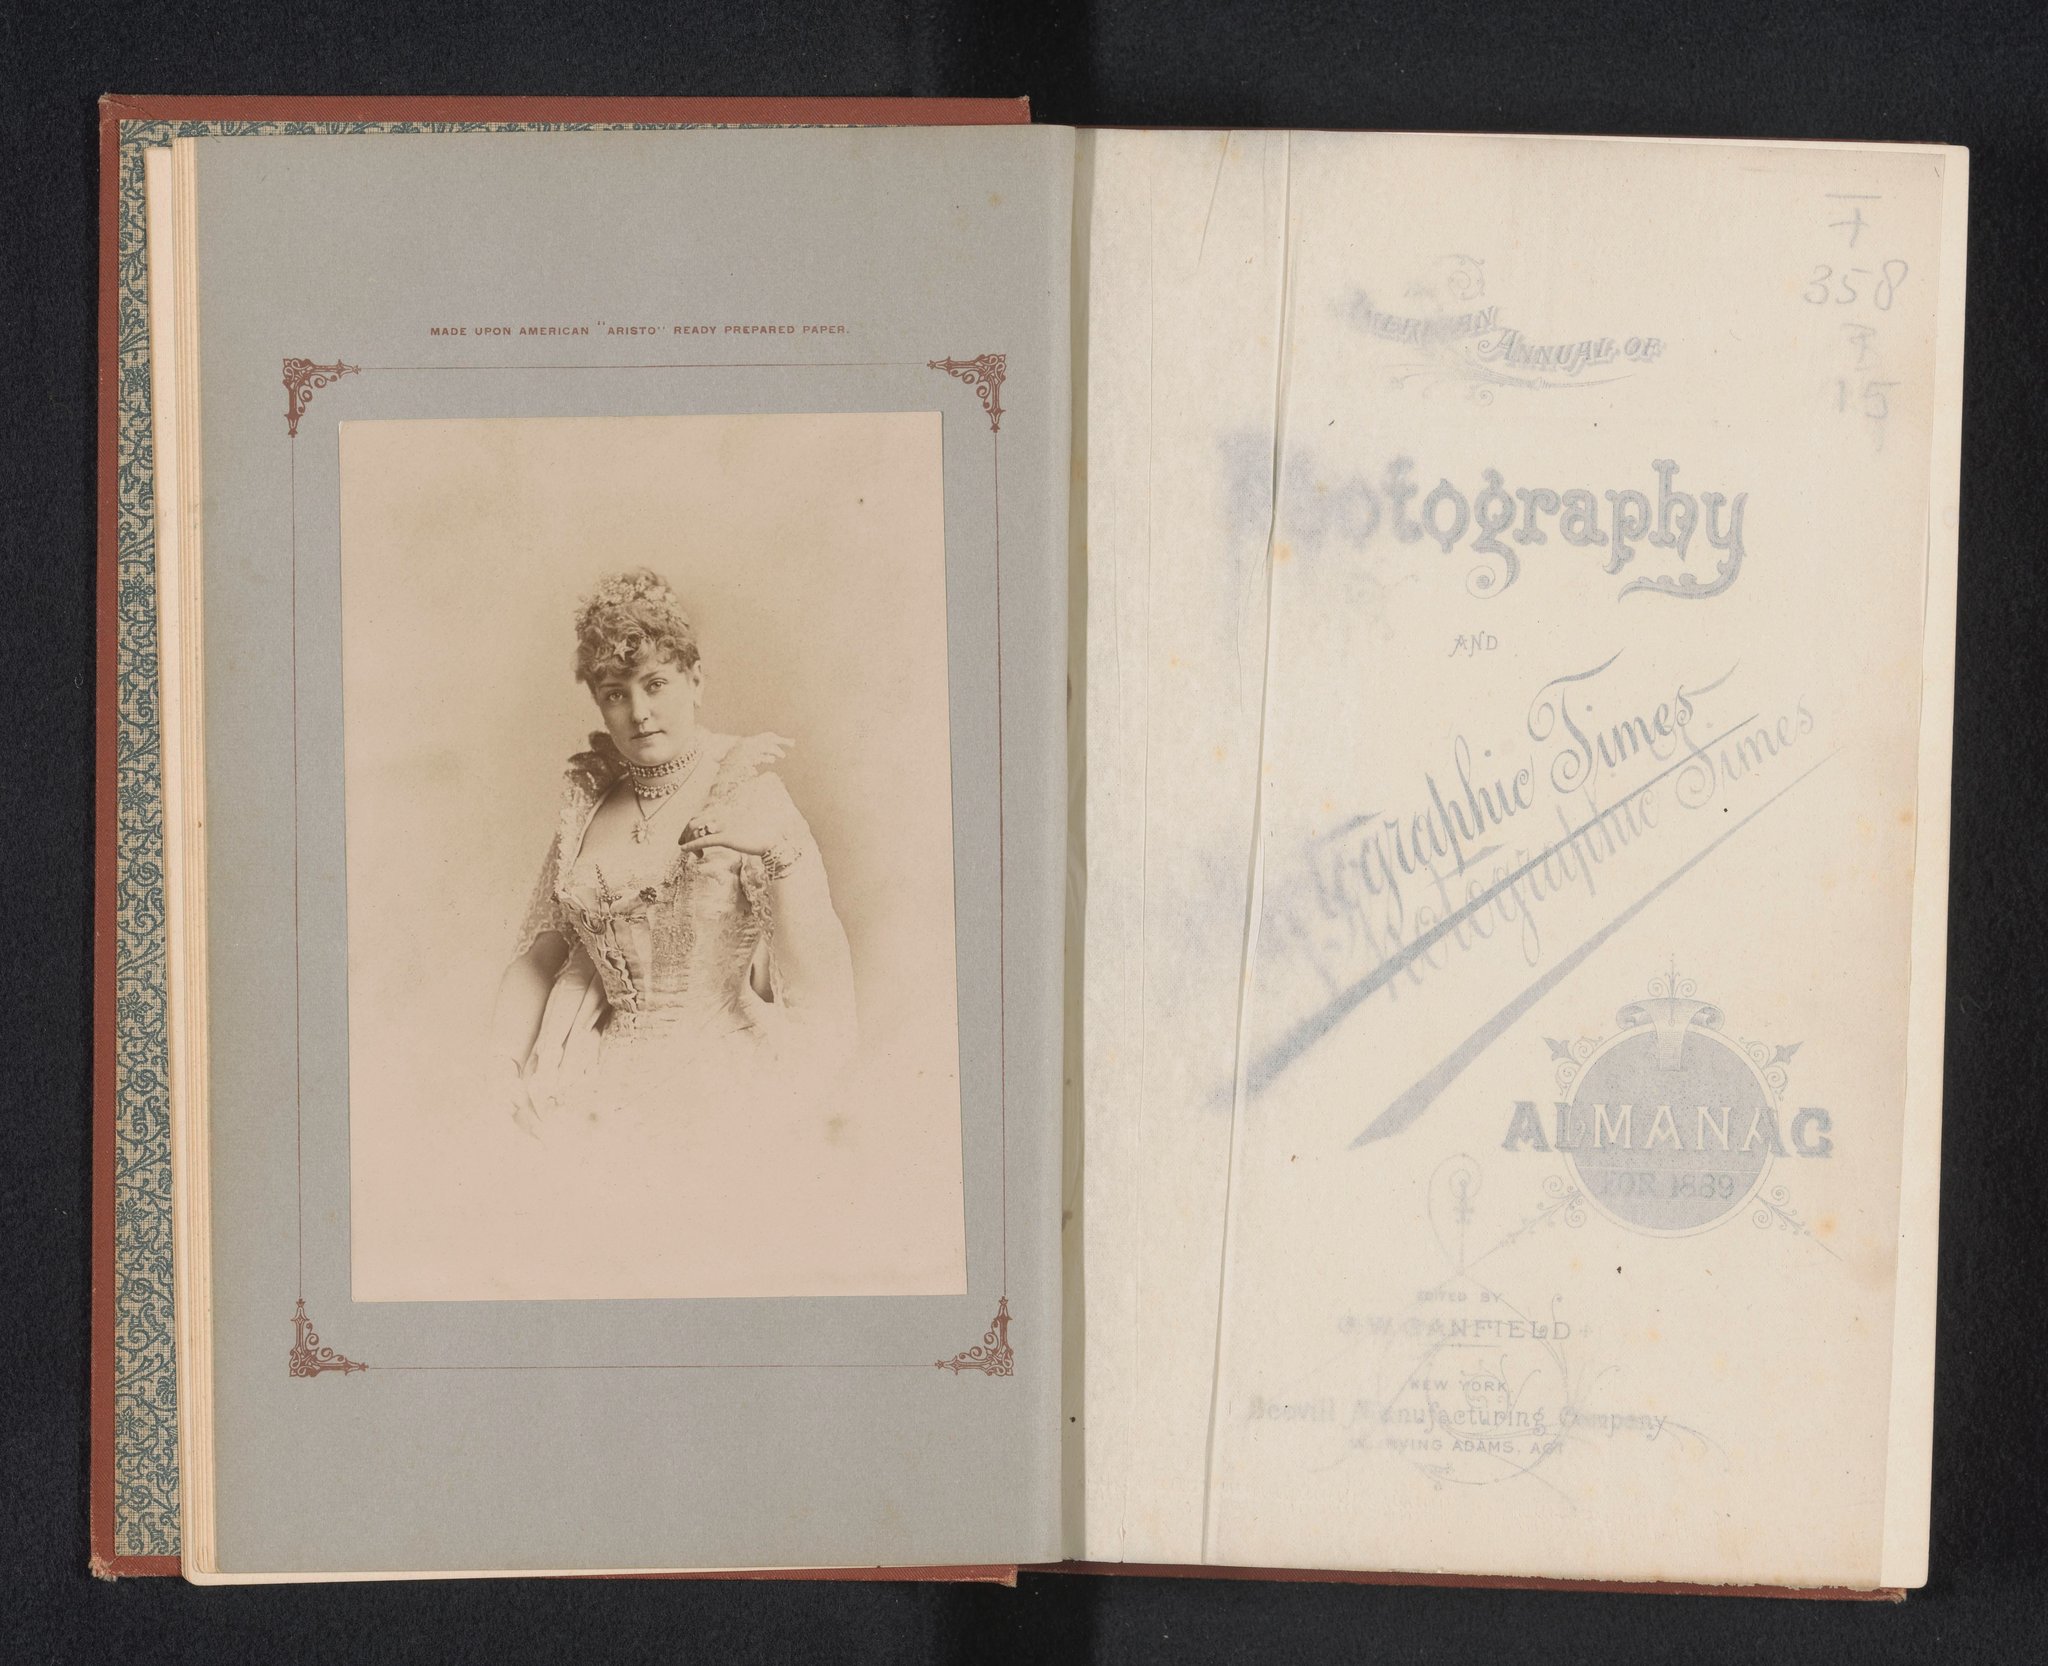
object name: photograph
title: Portret van een onbekende vrouw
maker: Anonymous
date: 1884-1889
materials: photographic support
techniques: gelatin silver print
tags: historical persons not known by name - bb - woman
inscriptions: inscription: ‘Made upon American "Aristo" Ready Prepared Paper’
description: Foto tegenover titelpagina, achter semi-transparante omslag.